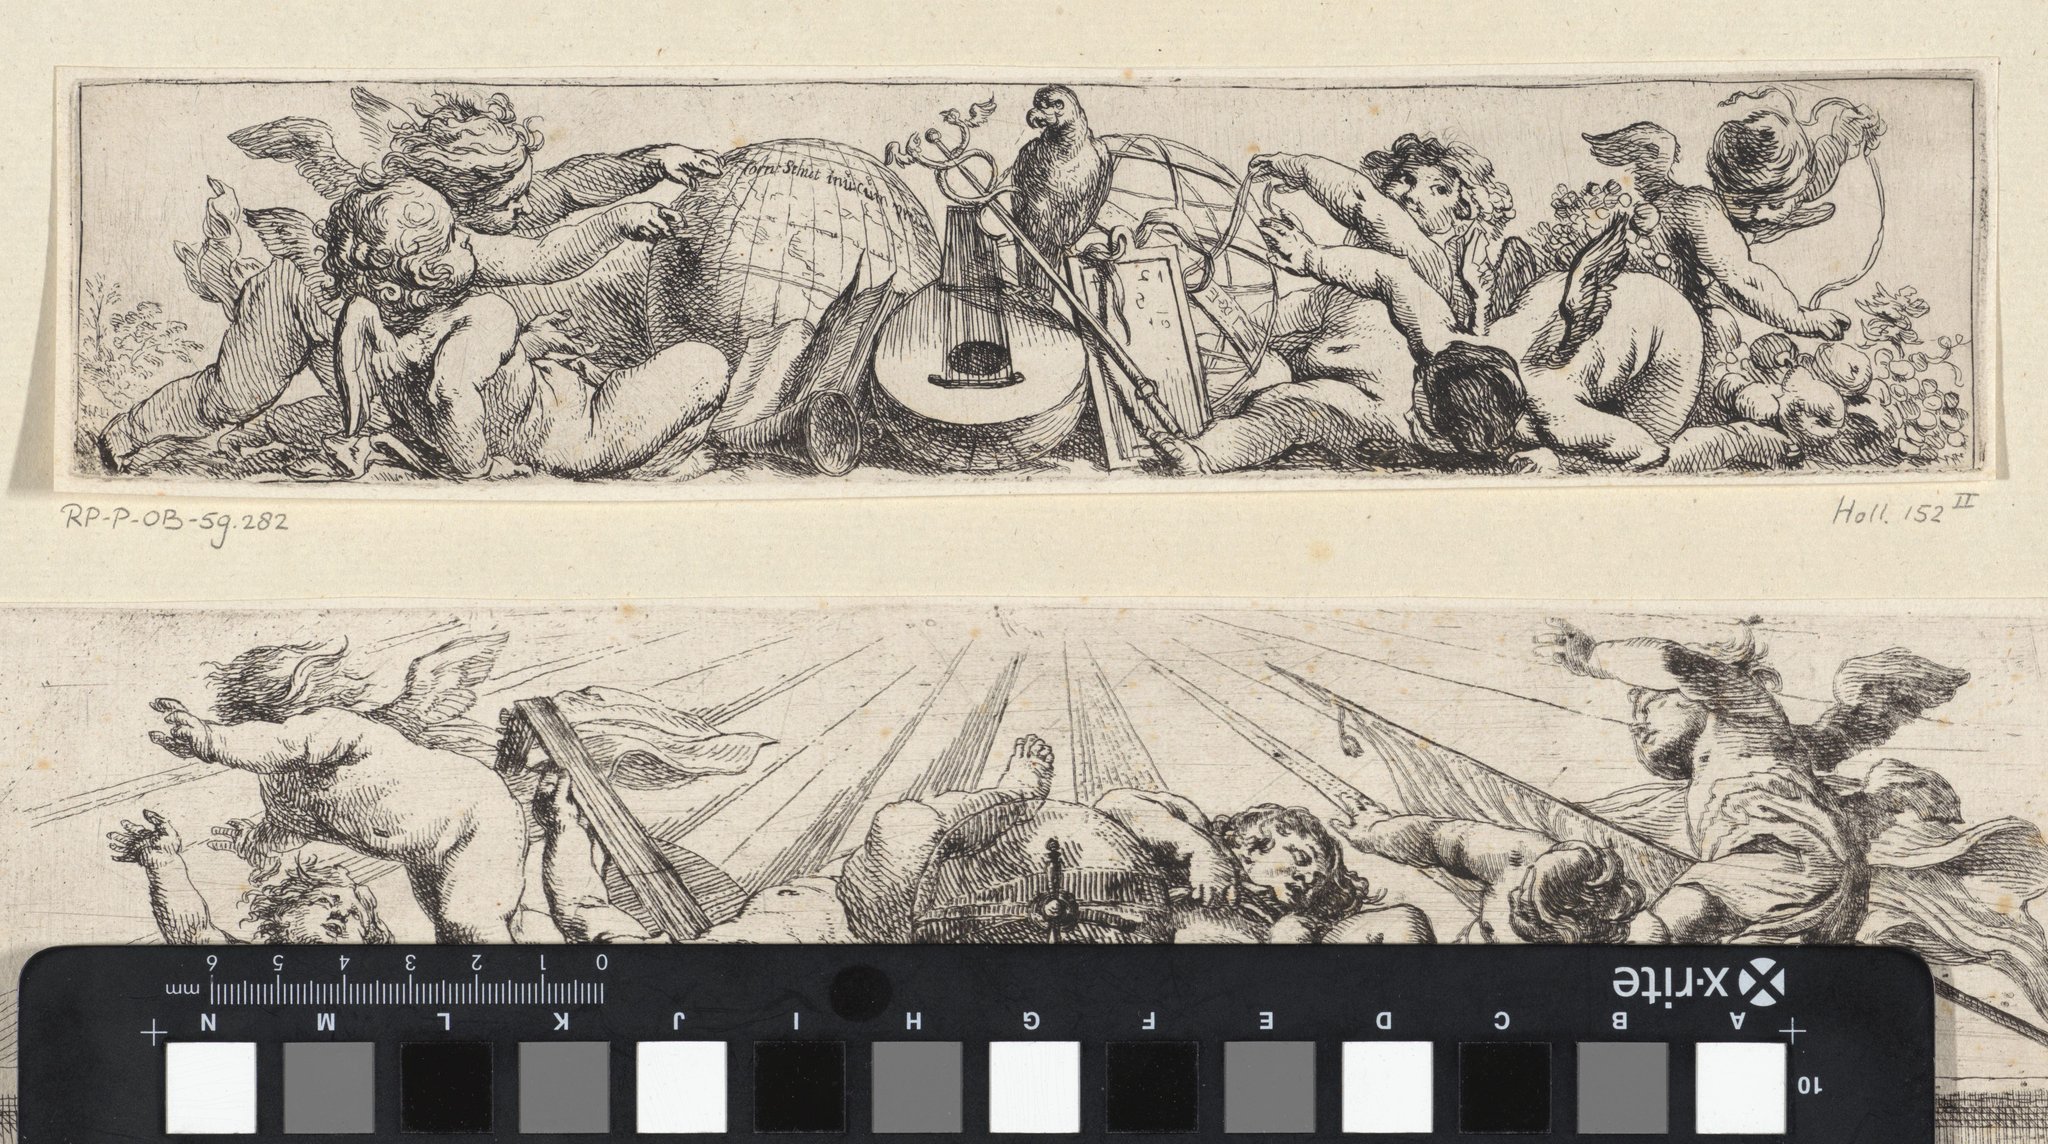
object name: print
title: Fries met vijf putti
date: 1618-1655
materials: paper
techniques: engraving, etching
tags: writing boards, ornamental birds: parrot, book - mm - book open, armillary sphere, skeleton celestial globe, lute, and special forms of lute, e.g.: theorbo, caduceus (staff with two snakes, attribute of mercury), globe, cupids: 'amores', 'amoretti', 'putti'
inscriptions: collector's mark: Lugt 240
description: Fries met vijf putti rondom een verzameling objecten: een luit, mercuriusstaf, boek, blaasinstrument en een schrijftafel met daarop een papegaai. Daarachter een globe en een armillarium.